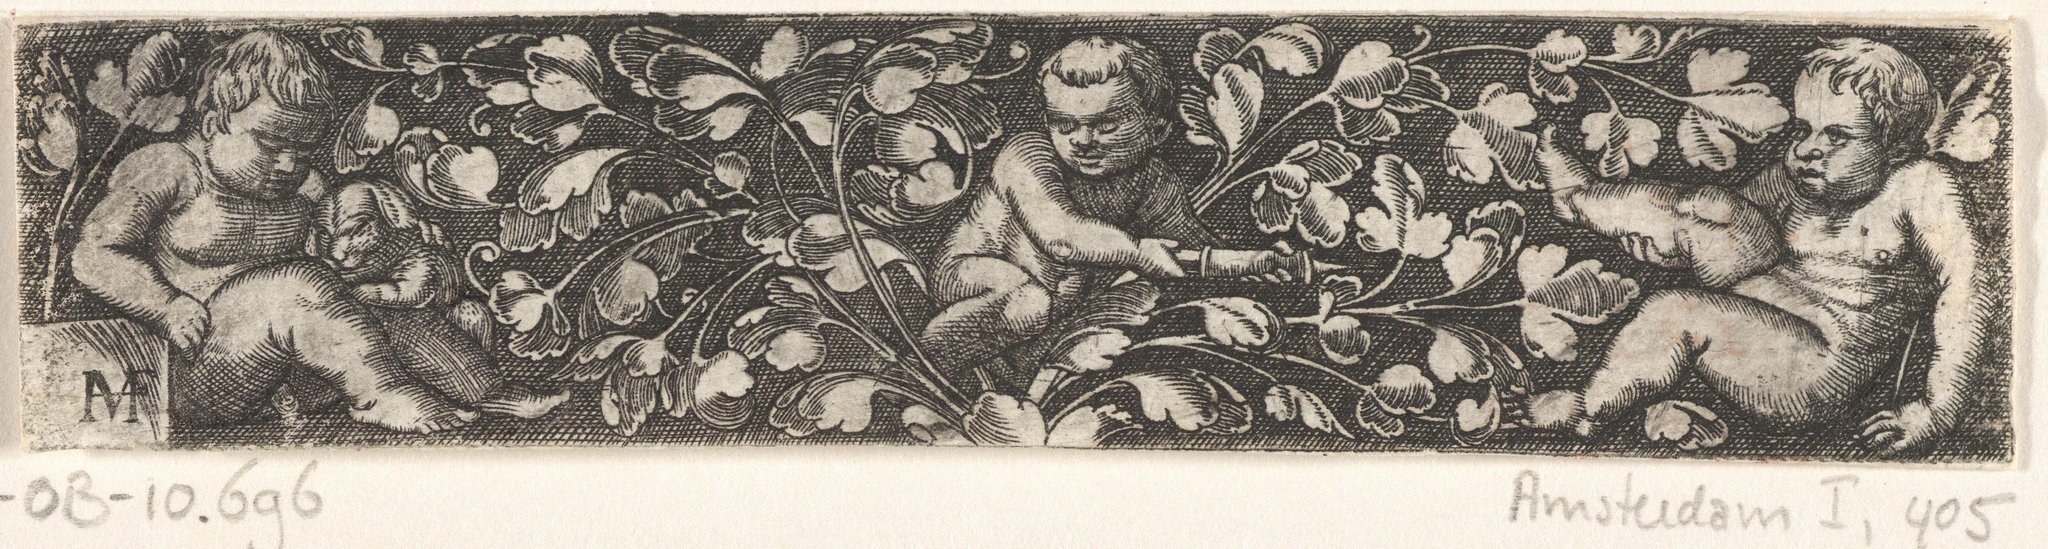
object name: ornament print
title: Fries met drie kinderen, zittend tussen bladranken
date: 1500-1600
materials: paper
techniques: engraving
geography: germany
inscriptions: collector's mark: Lugt 240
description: Het kind links heeft een hondje bij zich. Gearceerde achtergrond.